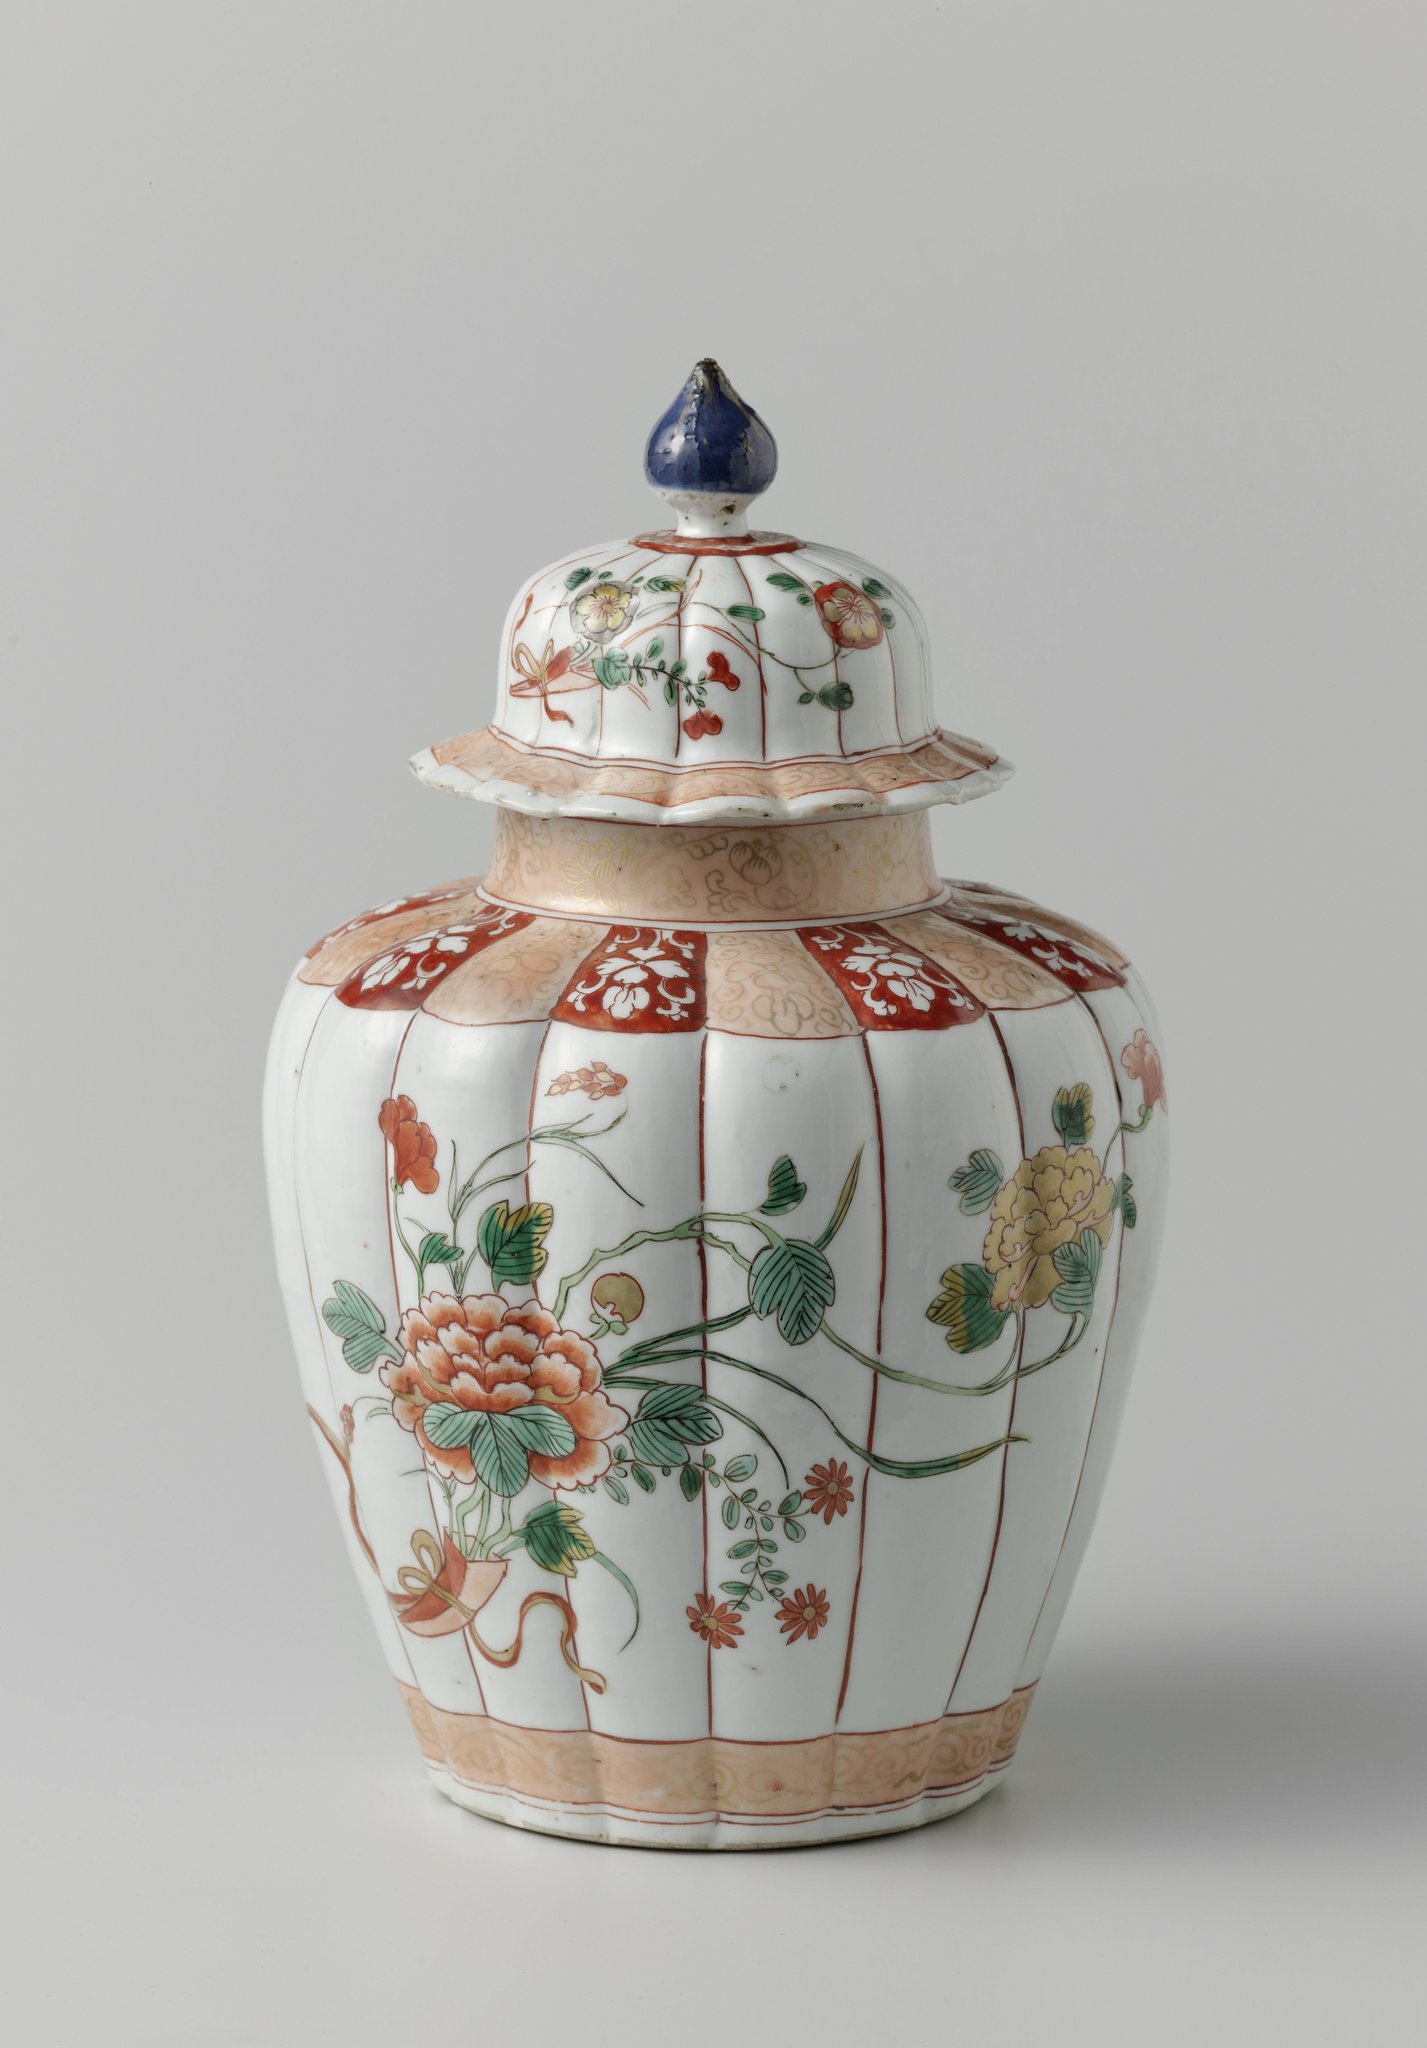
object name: covered jar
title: Lobed covered jar with two bouquets and flower scrolls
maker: Anonymous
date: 1725-1735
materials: cobalt, glaze, gold, paint, porcelain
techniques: forming, gilding, turning, vitrification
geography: china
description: Geribde eivormige dekselpot met een klokvormige deksel met dekselknop. Beschilderd in famille verte-kleuren met bloemboeketten. Op de hals en schouder banden met afwisselend witte ranken uitgespaard op een rode achtergrond en gouden ranken op een lichtrood fond.